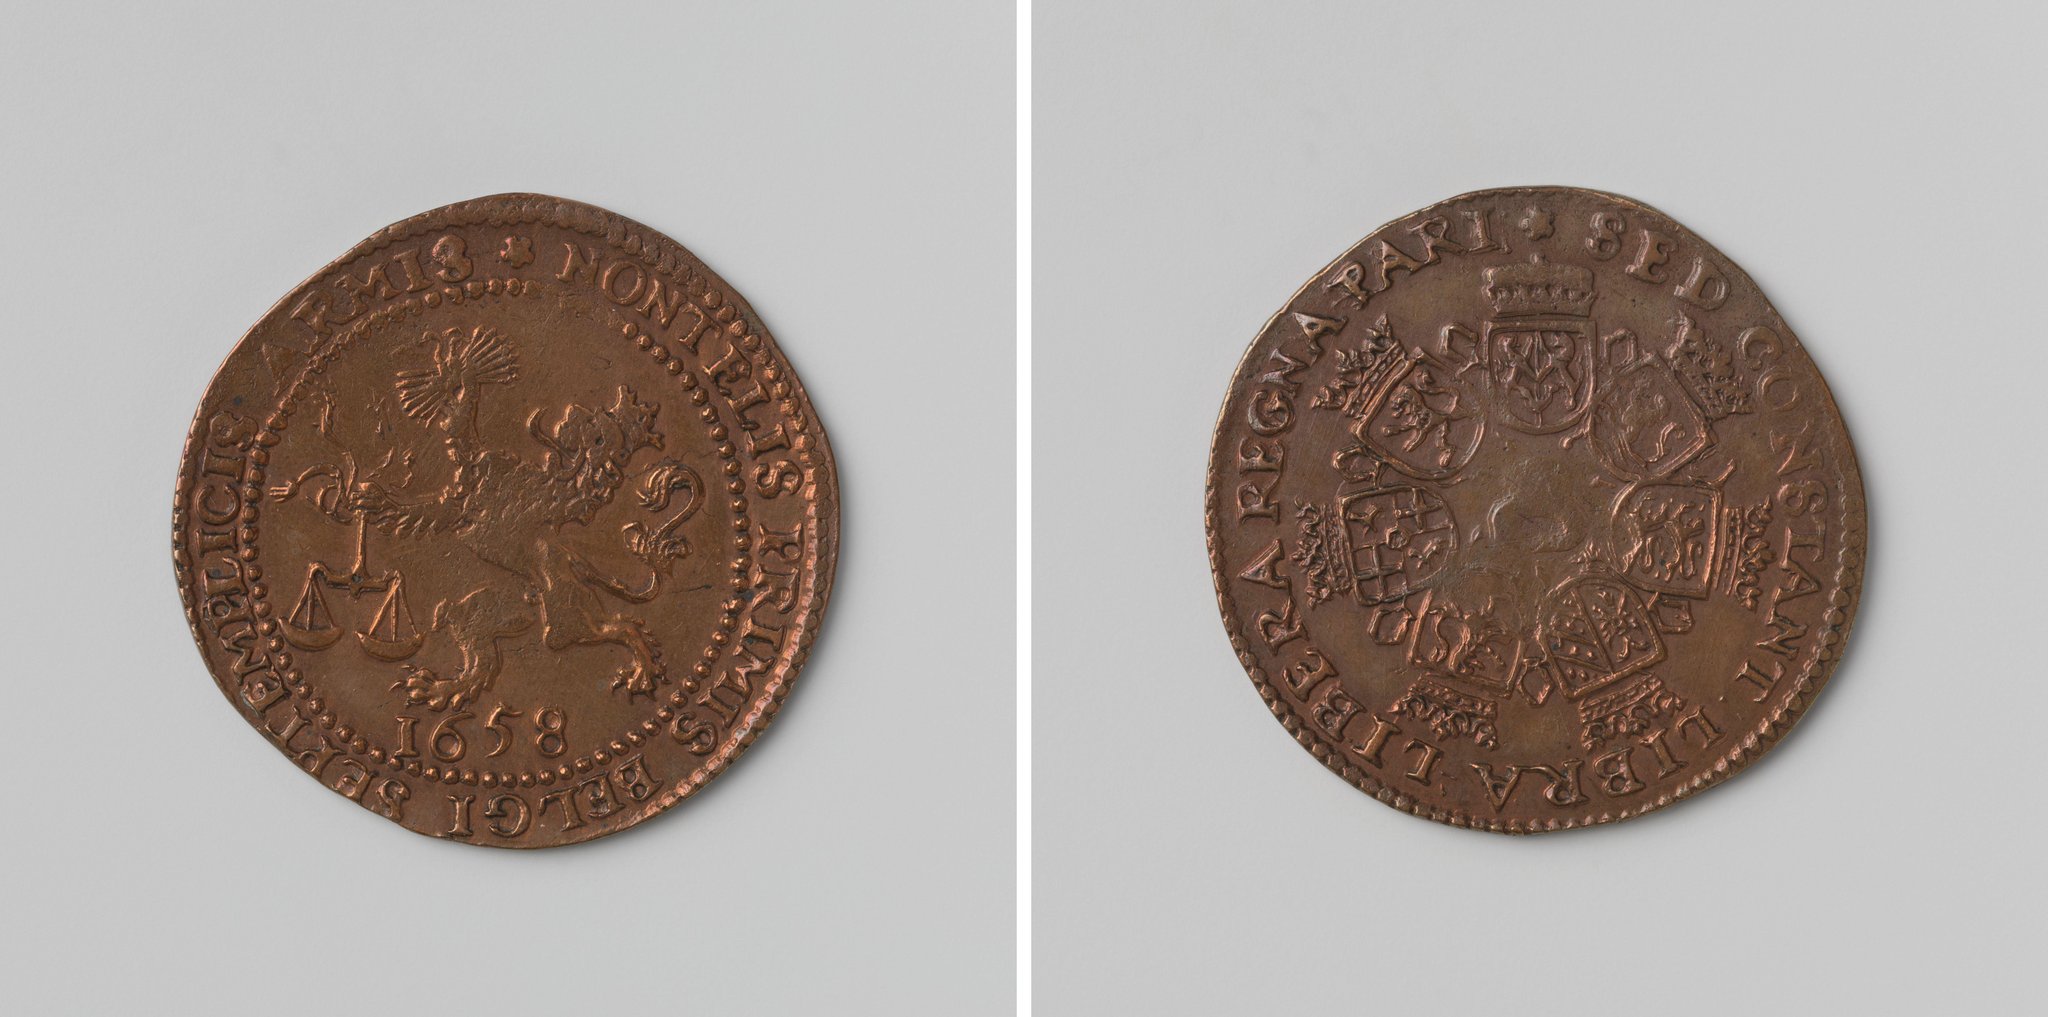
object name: jeton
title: Steun van de Verenigde Nederlanden aan Denemarken in de oorlog met Zweden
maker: Anonymous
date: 1658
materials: copper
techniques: striking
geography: netherlands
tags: faeröer, zweden, noordse oorlogen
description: Koperen penning. Voorzijde: gekroonde leeuw met bundel van zeven pijlen in rechter- en weegschaal in linkerklauw boven jaartal binnen omschrift. Keerzijde: vrijheidshoed, omgeven door rand van zeven met lint samengebonden gekroonde wapenschilden binnen omschrift